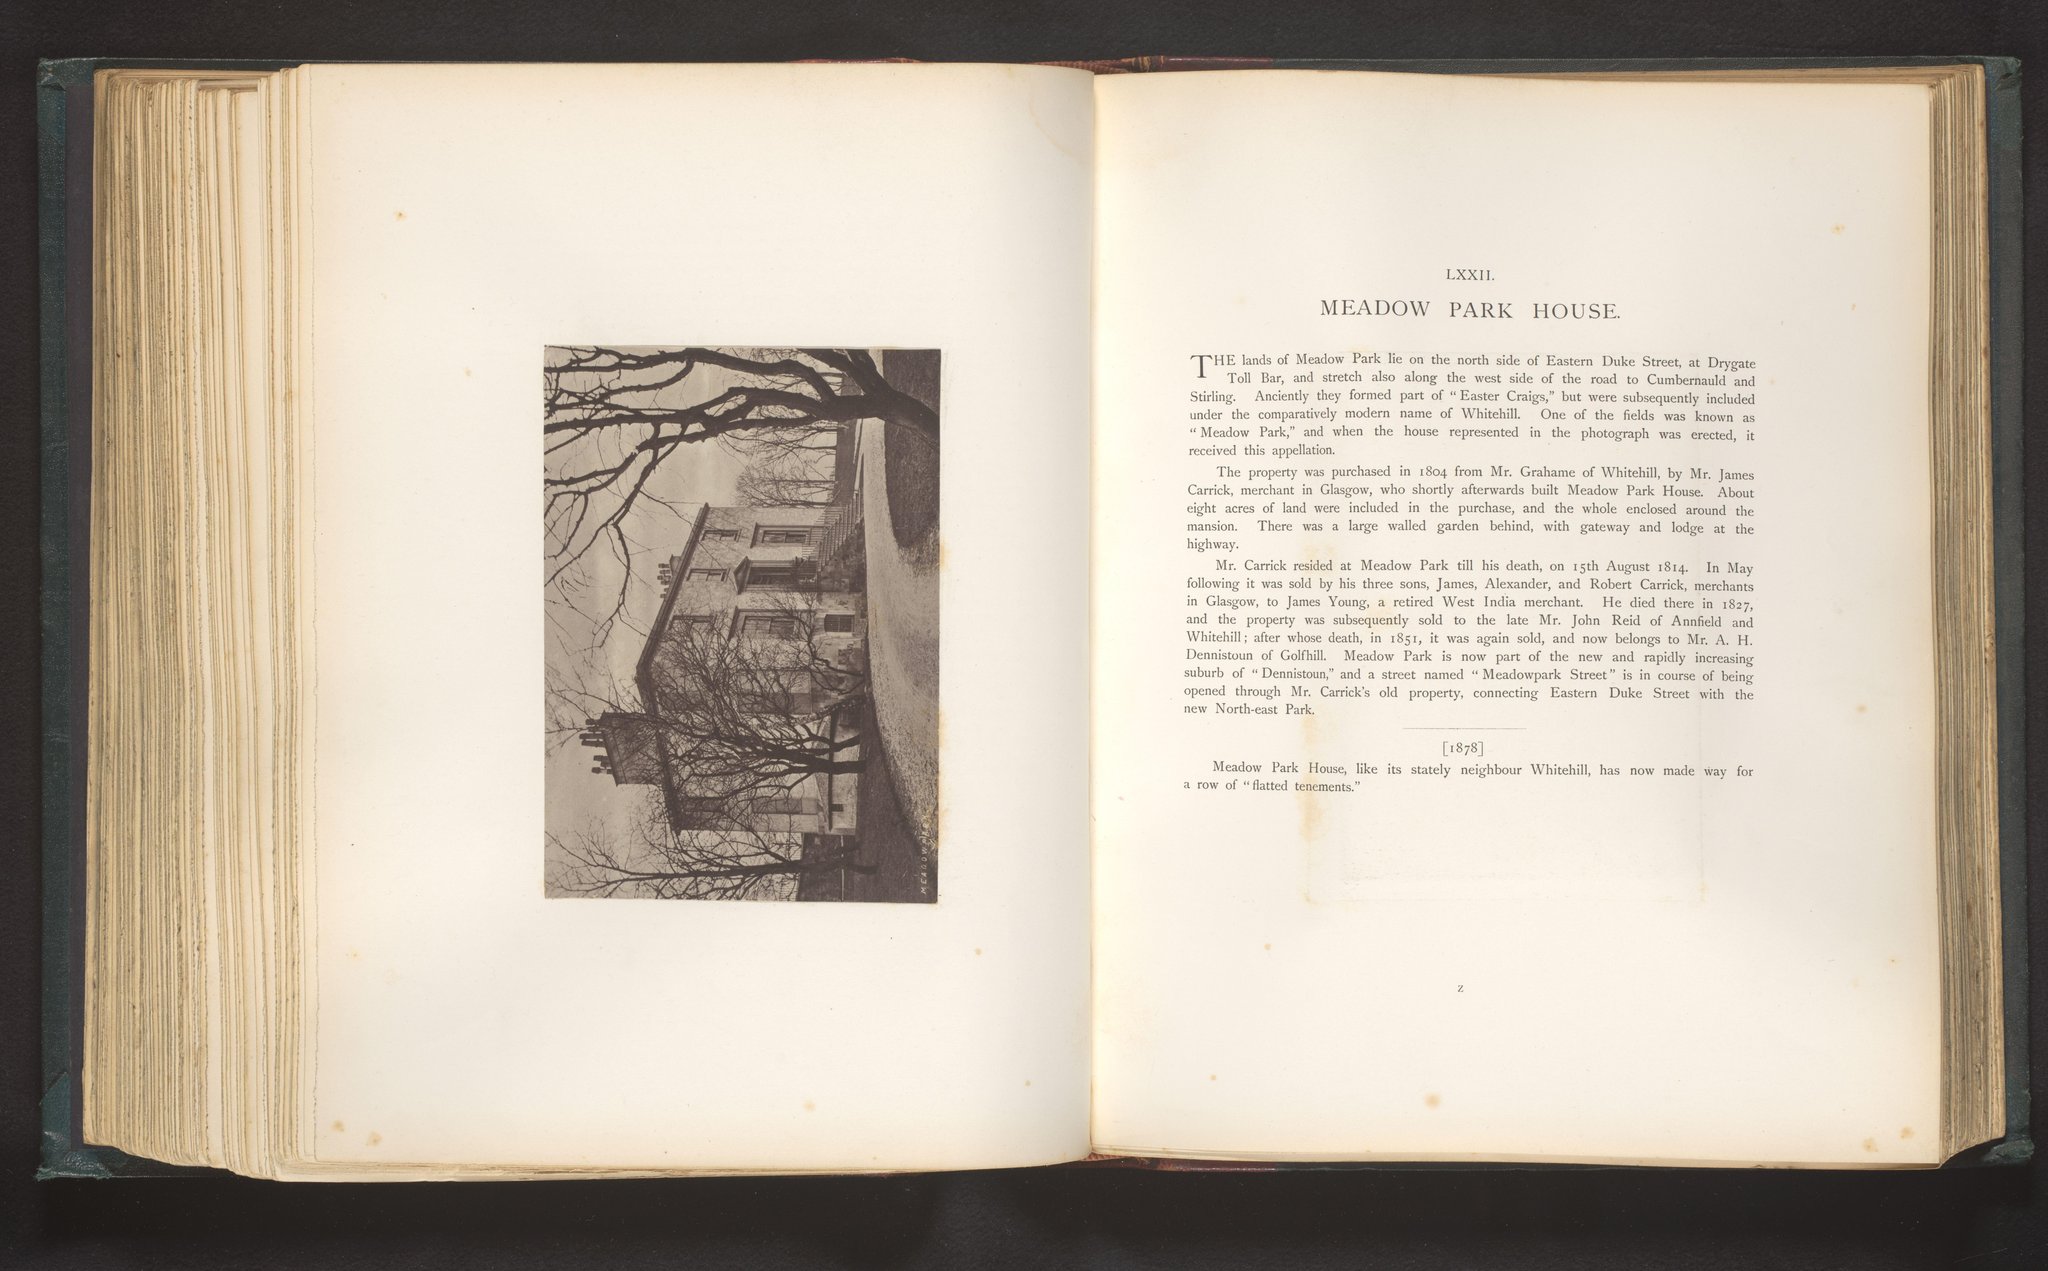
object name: page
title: Meadow Park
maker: thomas annan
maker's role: fotograaf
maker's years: 1829-1887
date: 1868-1878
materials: paper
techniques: carbon print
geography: glasgow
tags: rural housing, e.g. country-house, villa, cottage, façade (of house or building)